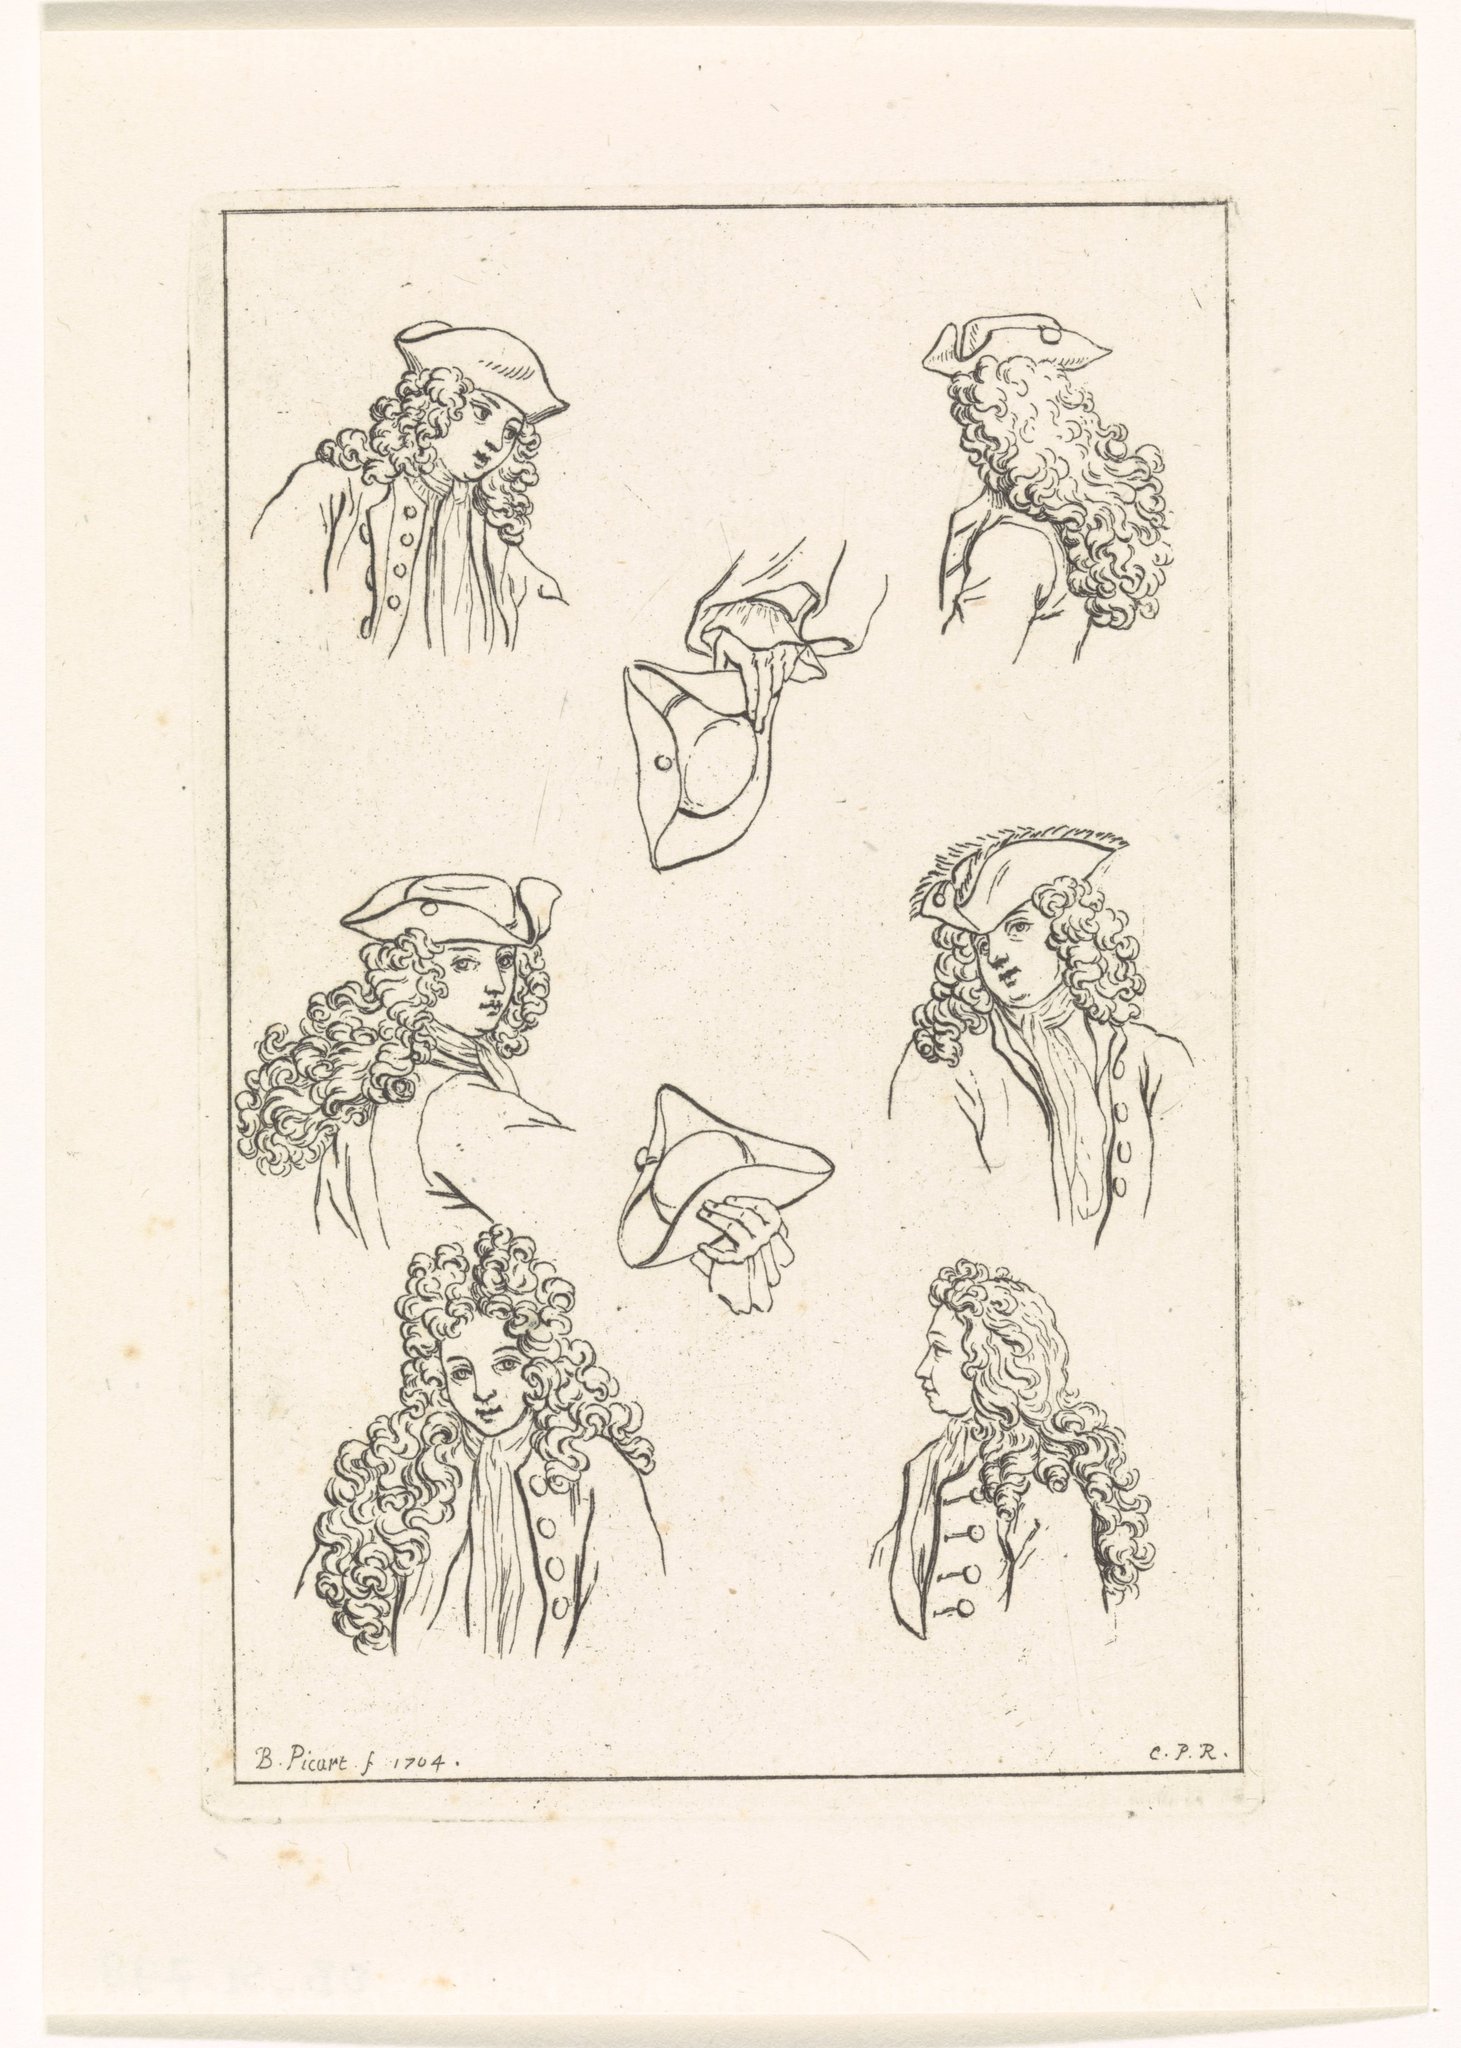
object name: print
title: Allerlei houdingen van mannenhoofden en manieren om een hoed te dragen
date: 1704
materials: paper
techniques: etching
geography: paris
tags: head-gear: tricorn (+ men's clothes), head (human), styles of hairdress (allonge)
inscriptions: date